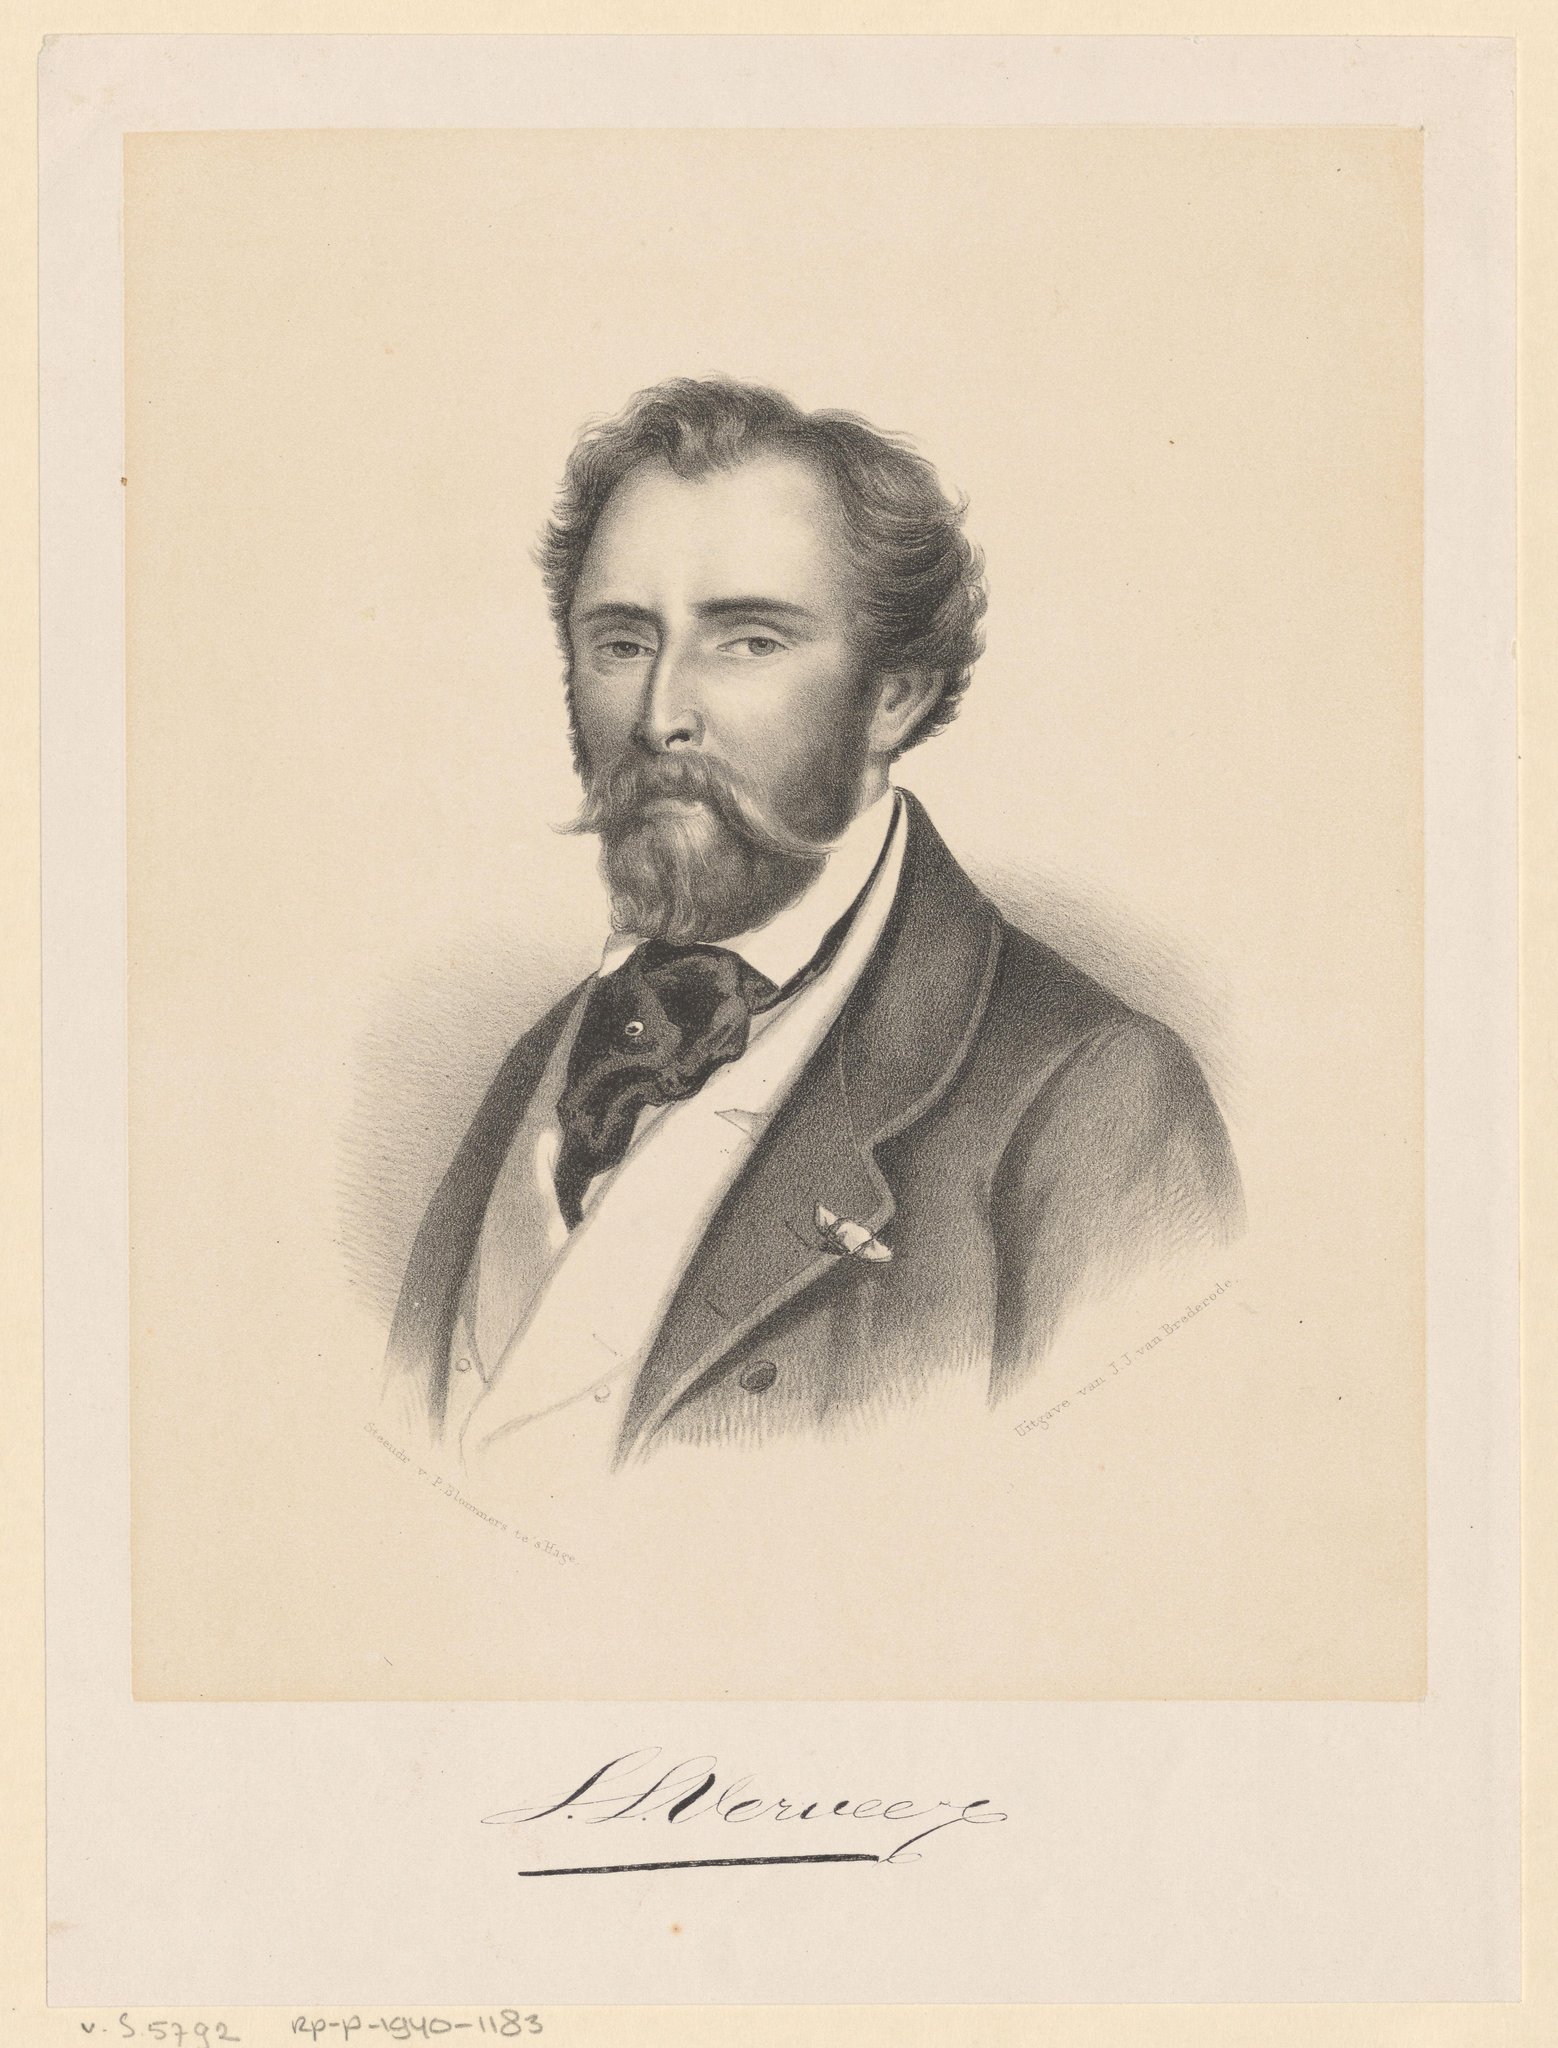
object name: print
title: Portret van Samuel Leonardus Verveer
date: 1847-1883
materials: paper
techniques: tone lithography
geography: the hague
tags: the hague, salomon leonardus verveer, historical persons, portrait, self-portrait of painter, portrait, self-portrait of graphic artist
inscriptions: collector's mark: Lugt 2228, collector's mark: Lugt 2760